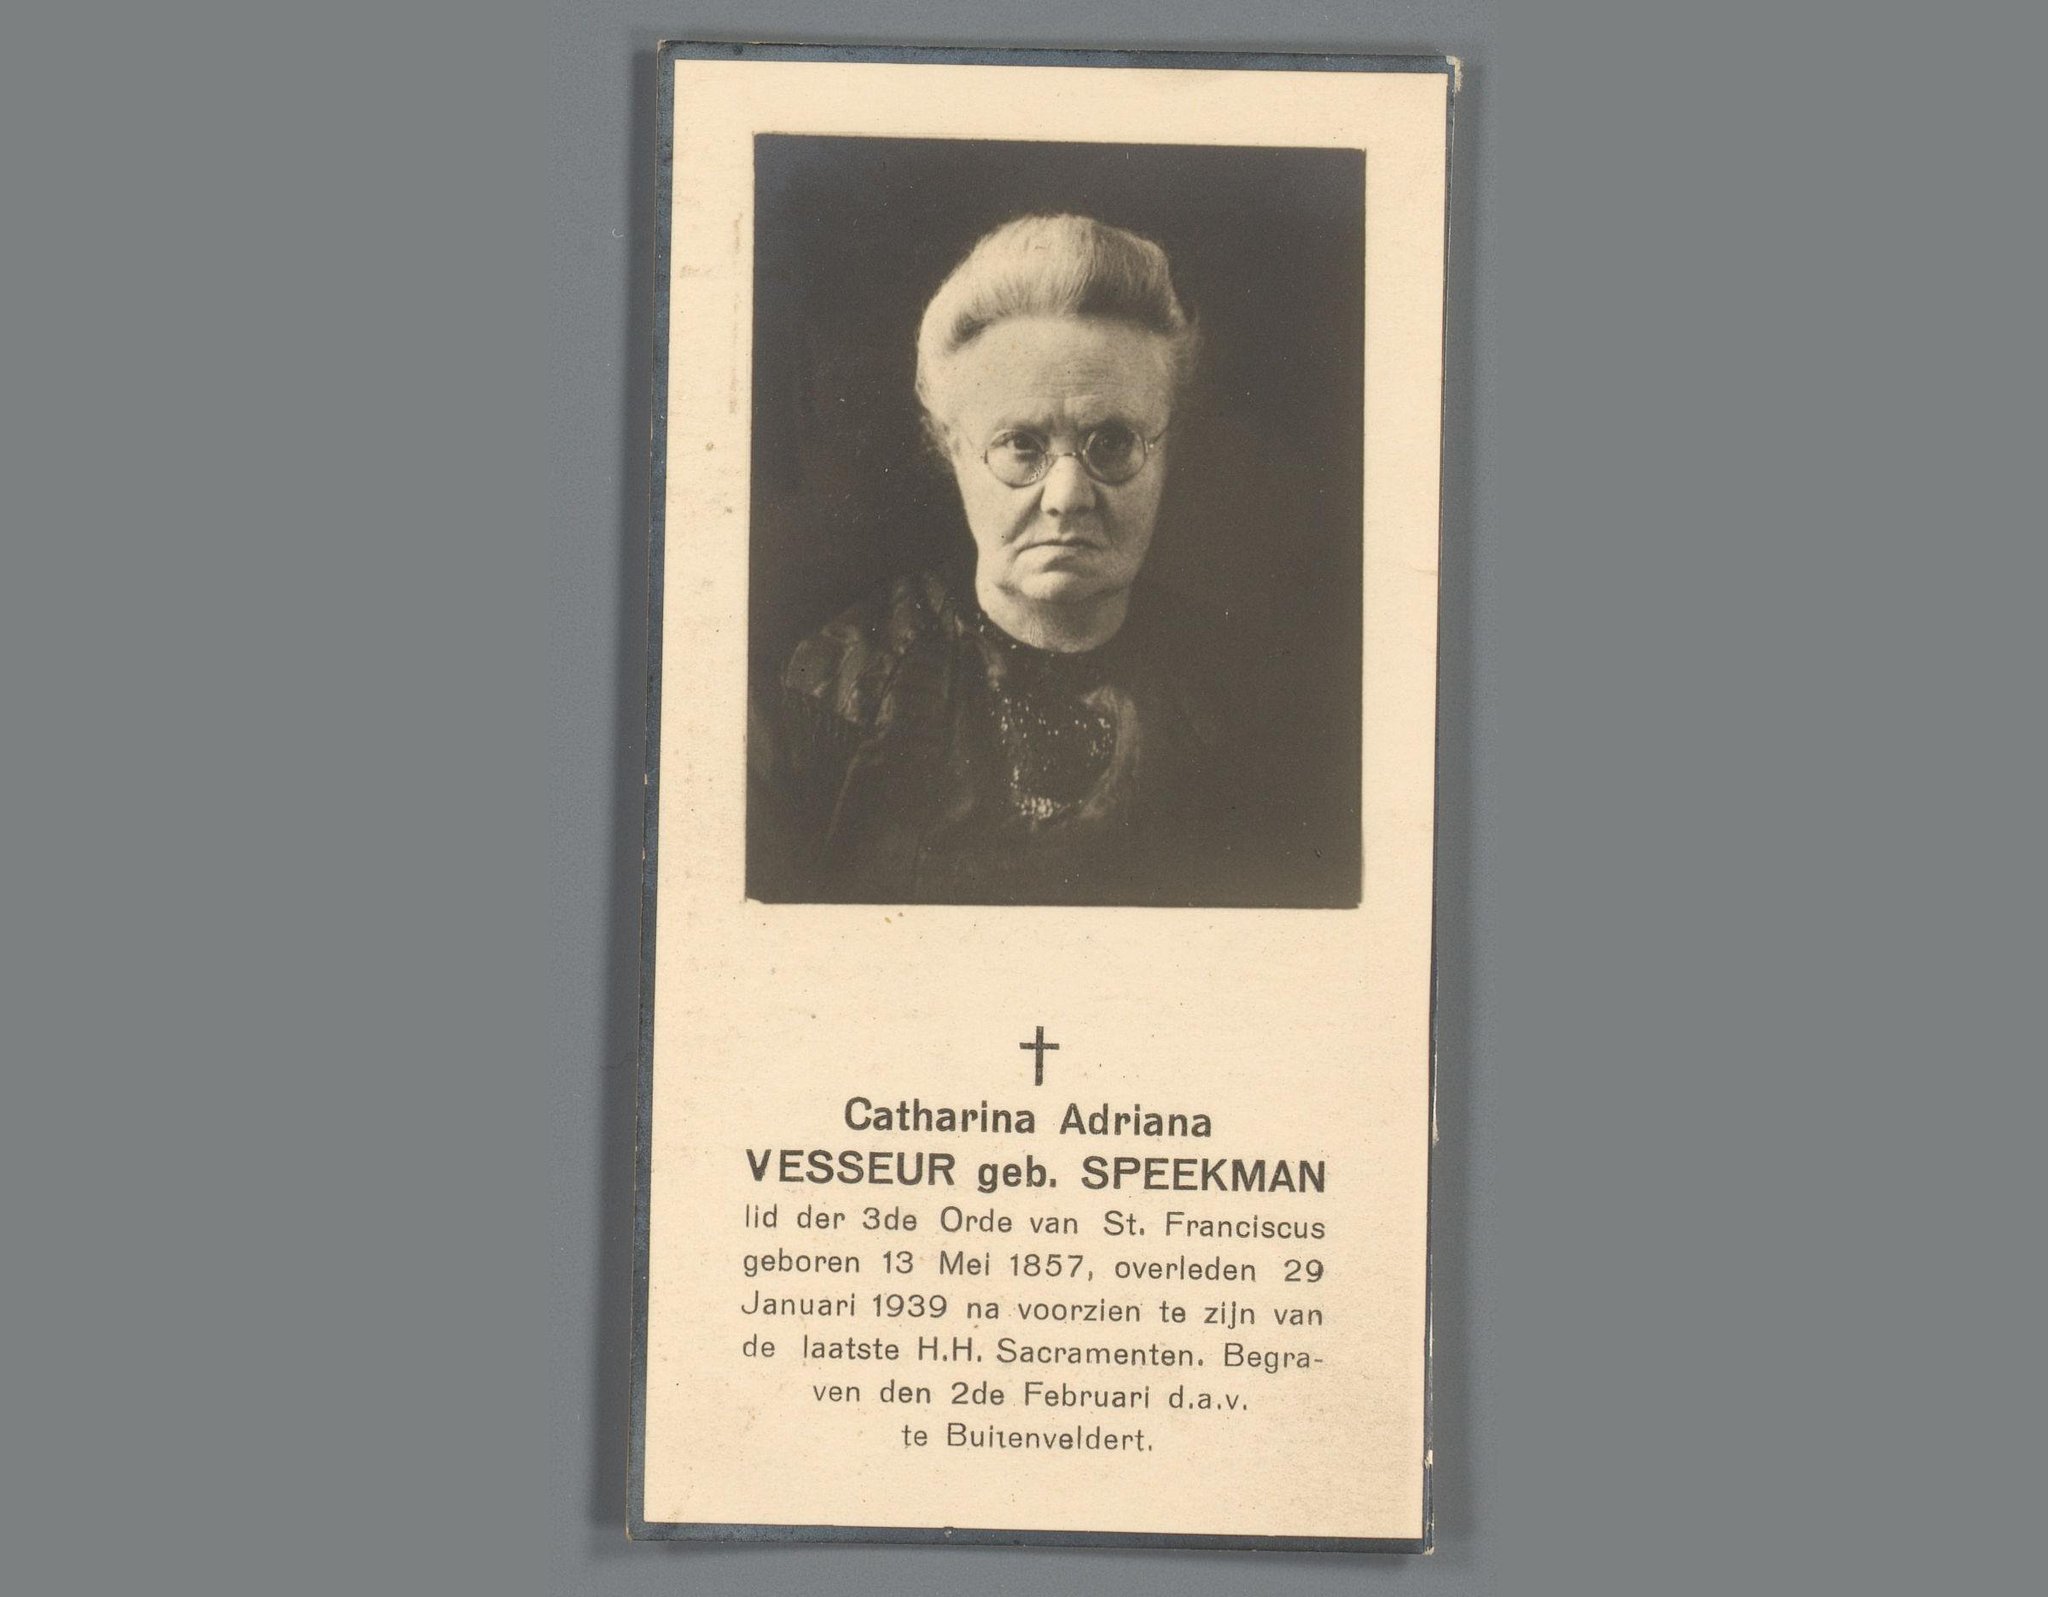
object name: prayer card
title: Portret van Catharina Adriana Vesseur-Speekman op bidprent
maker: Anonymous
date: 1939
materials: paper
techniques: gelatin silver print, letterpress printing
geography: amsterdam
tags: historical persons, old woman, amsterdam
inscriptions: inscription: ‘Gedenk in uwe gebeden de ziel van/ onze lieve moeder (...) Rust in God’, inscription: ‘Catharina Adriana (...) te Buitenveldert.’